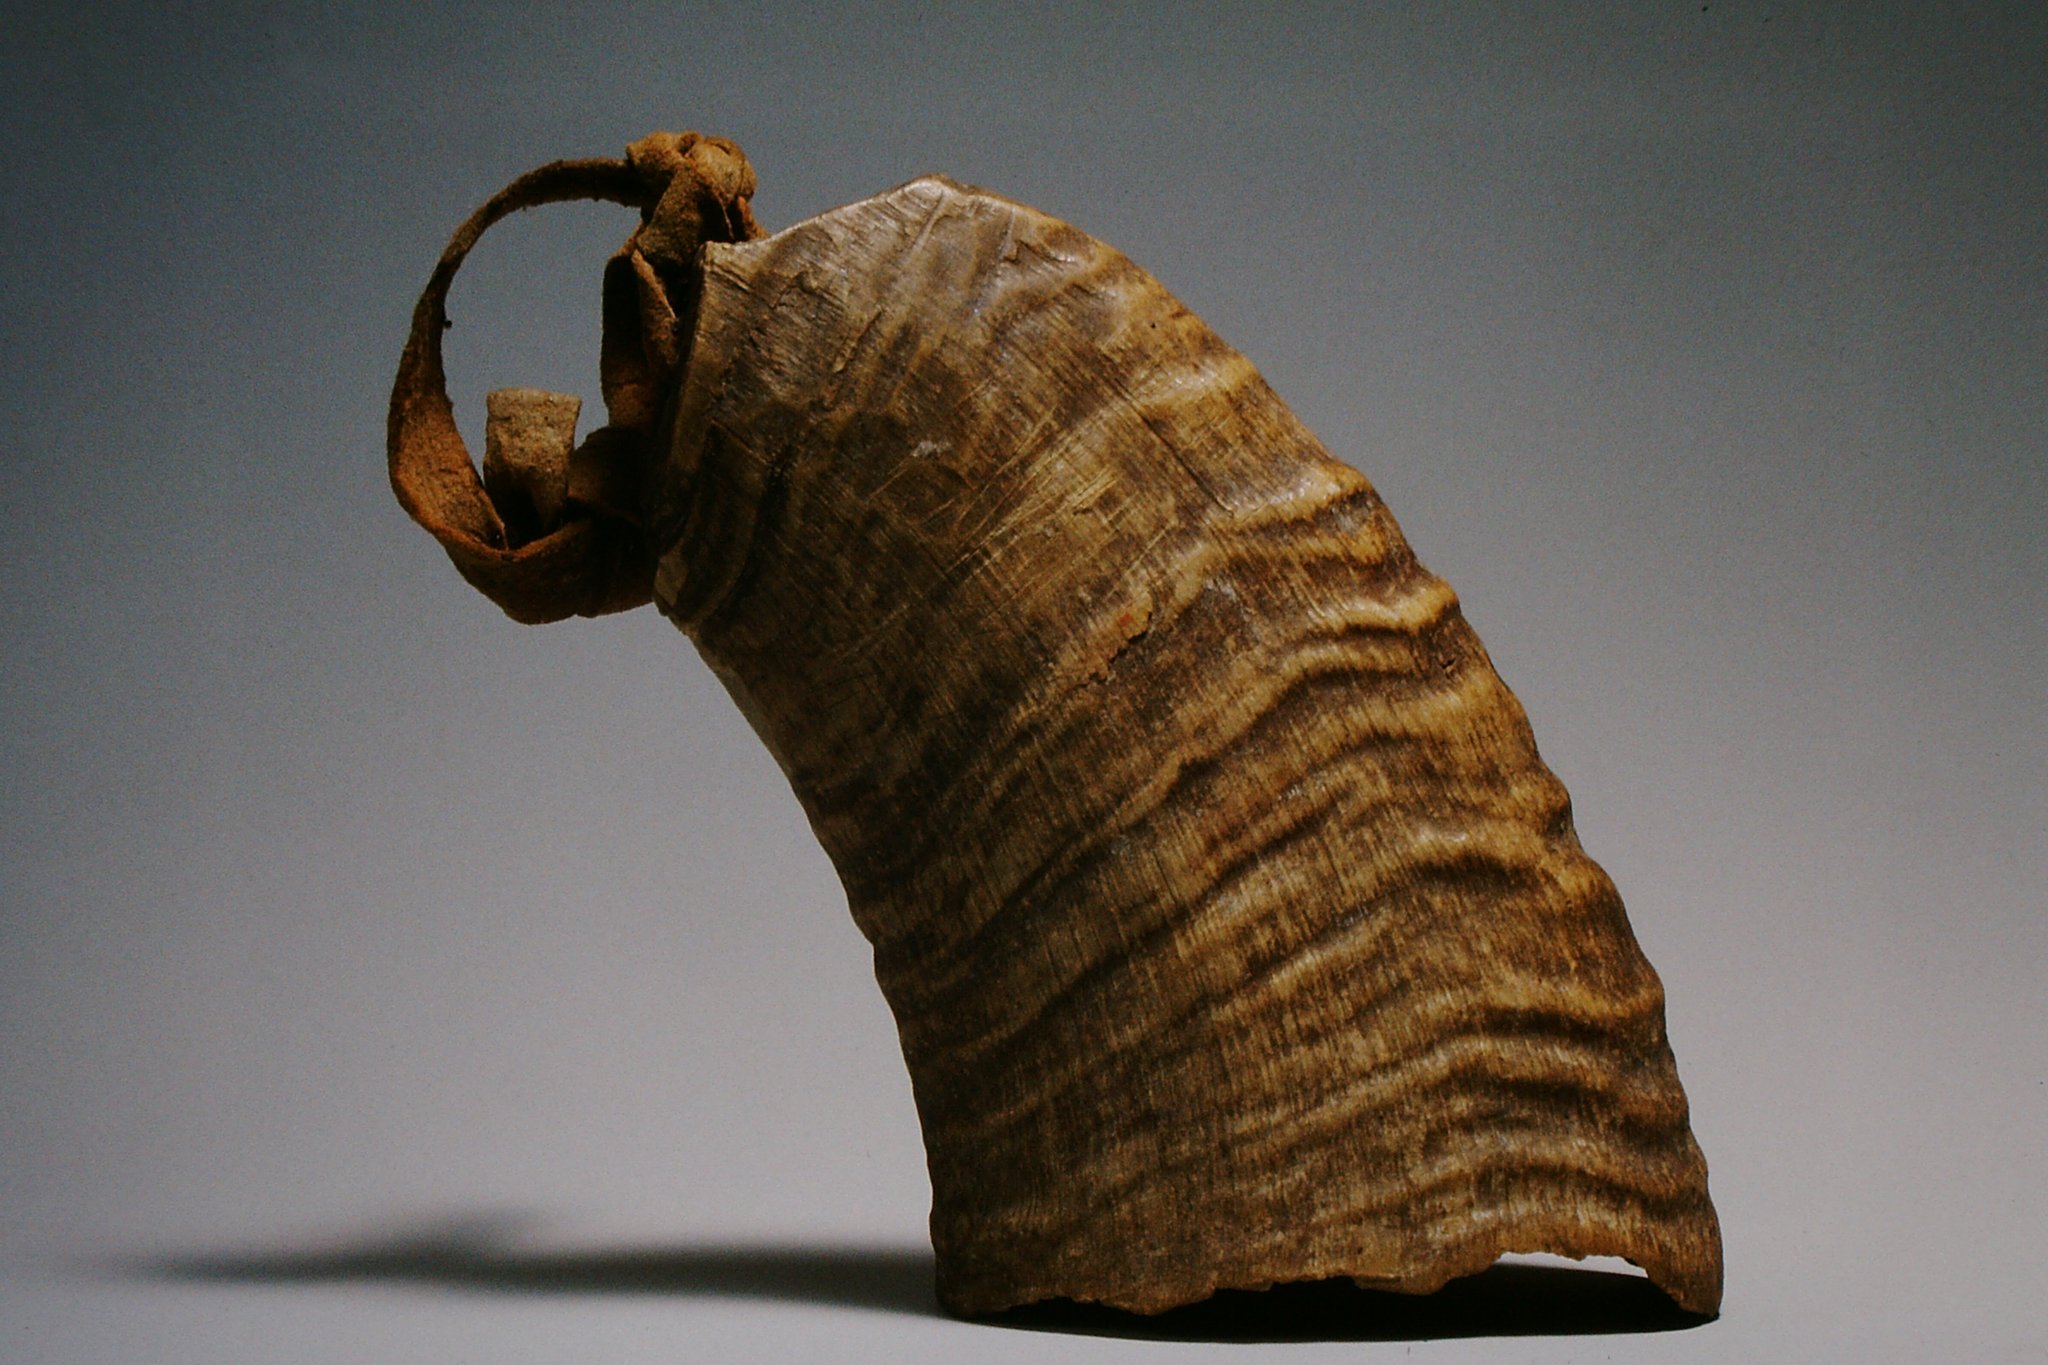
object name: bell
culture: native american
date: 1801-1900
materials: horn, stone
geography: united states